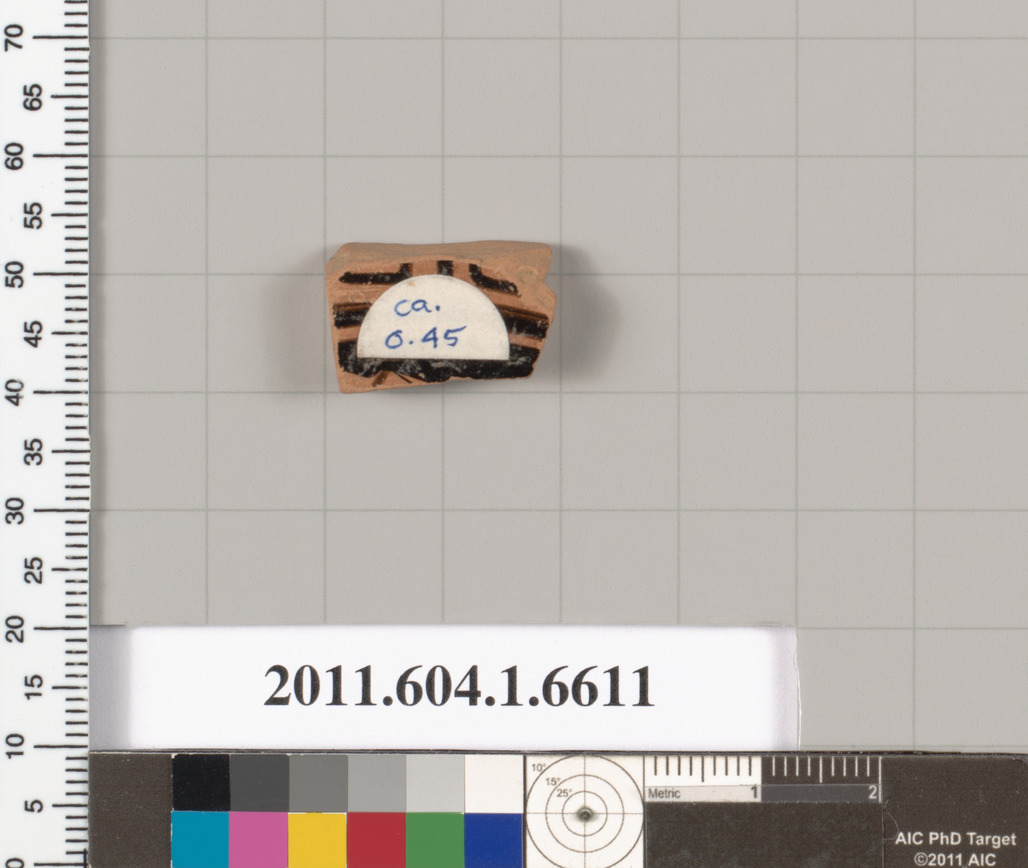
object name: kylix fragment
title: Terracotta fragment of a kylix (drinking cup)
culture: greek, attic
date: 490-470 BCE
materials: terracotta